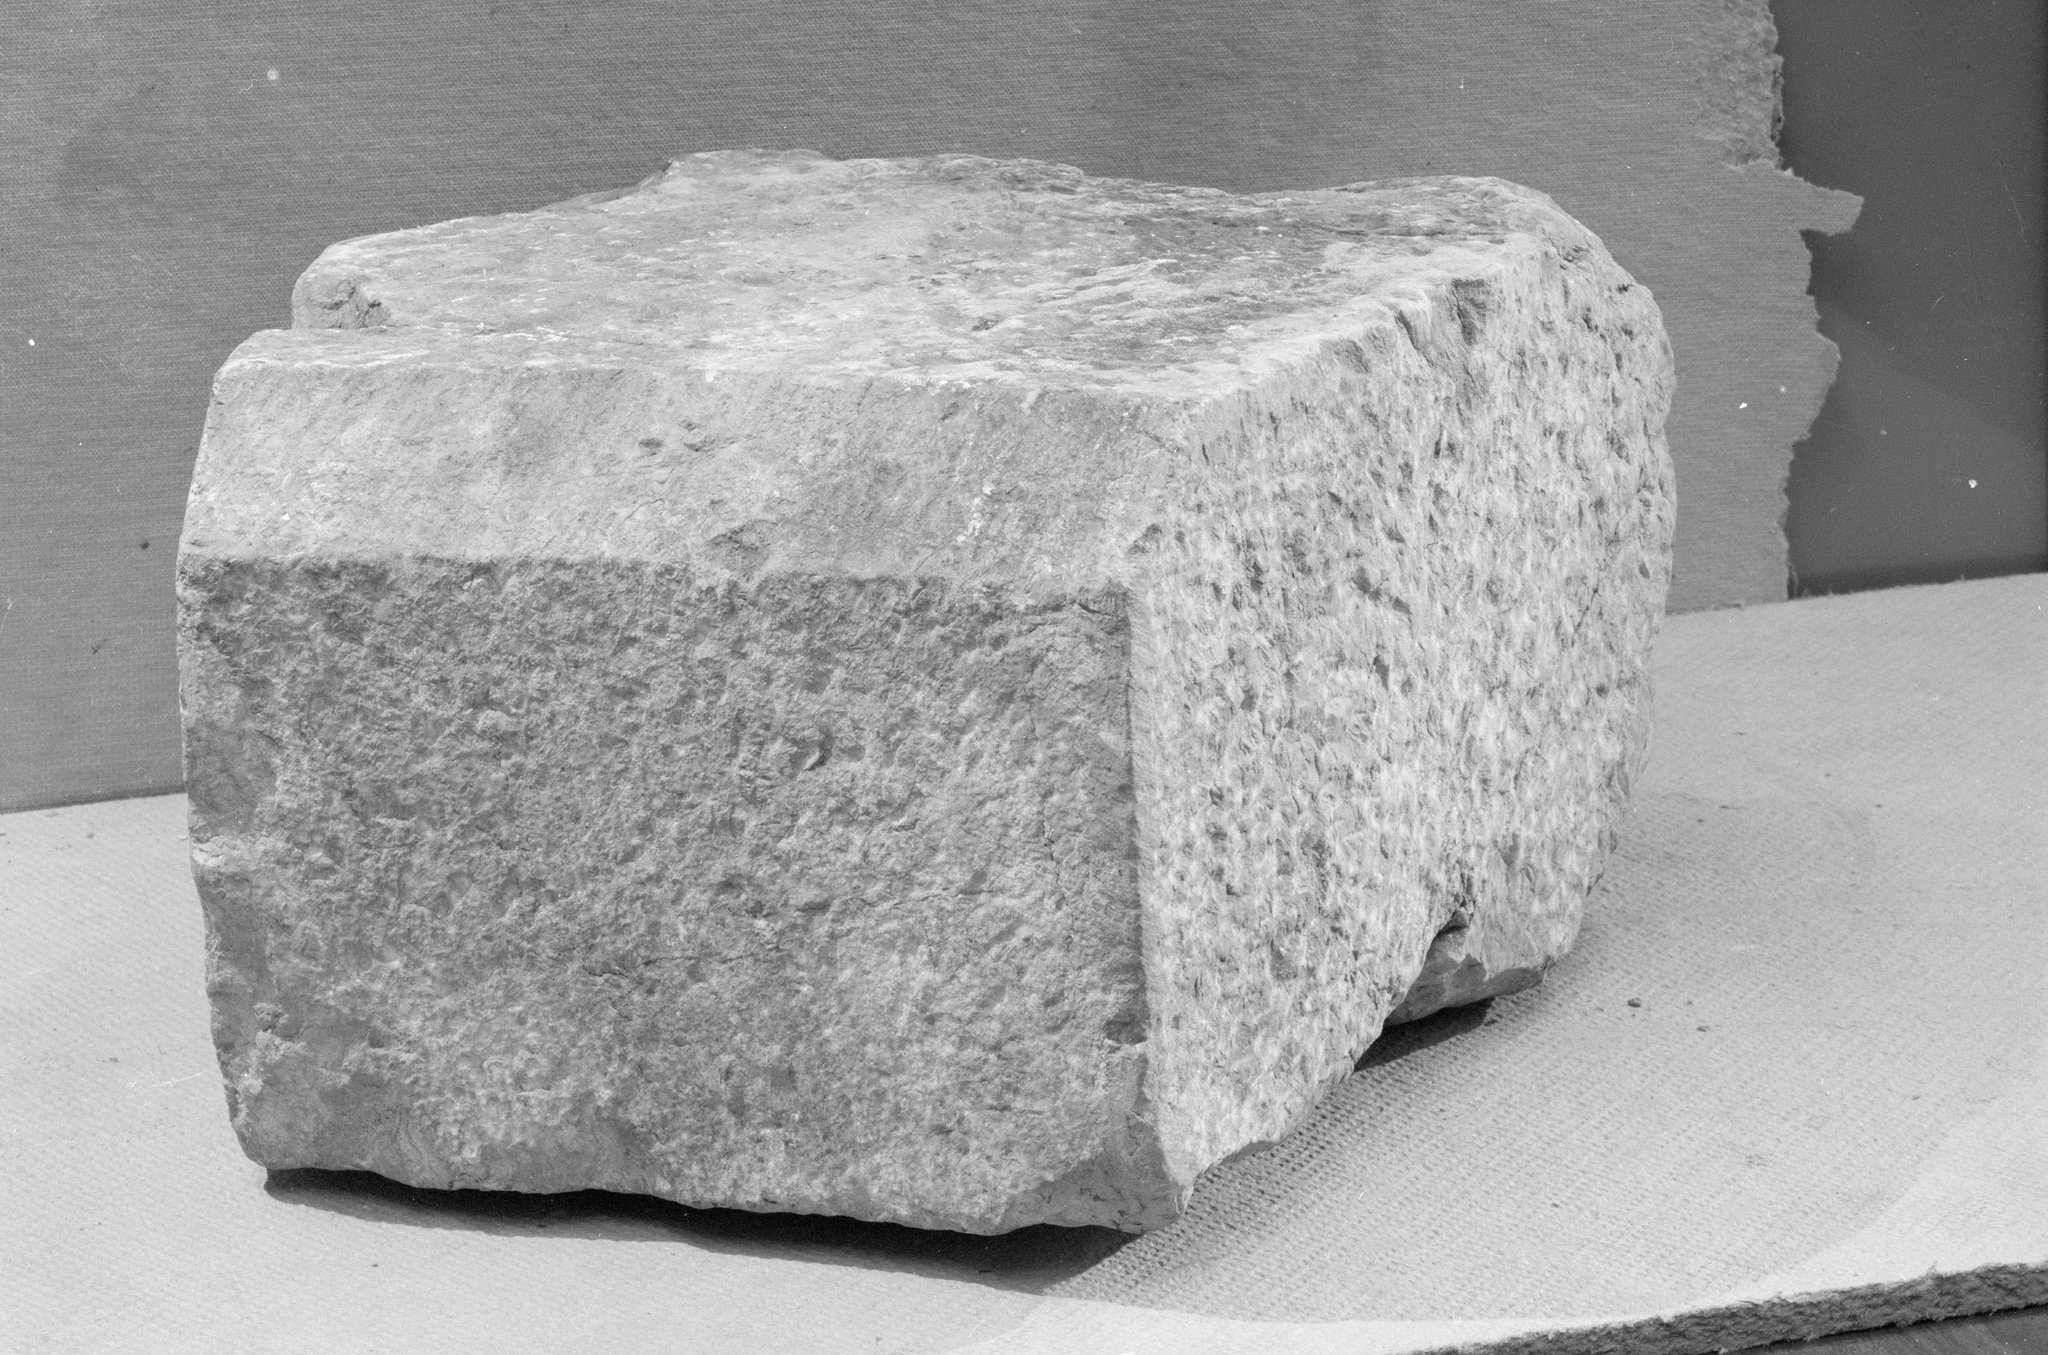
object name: block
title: Block Fragment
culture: french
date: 1130-1140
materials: stone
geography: france